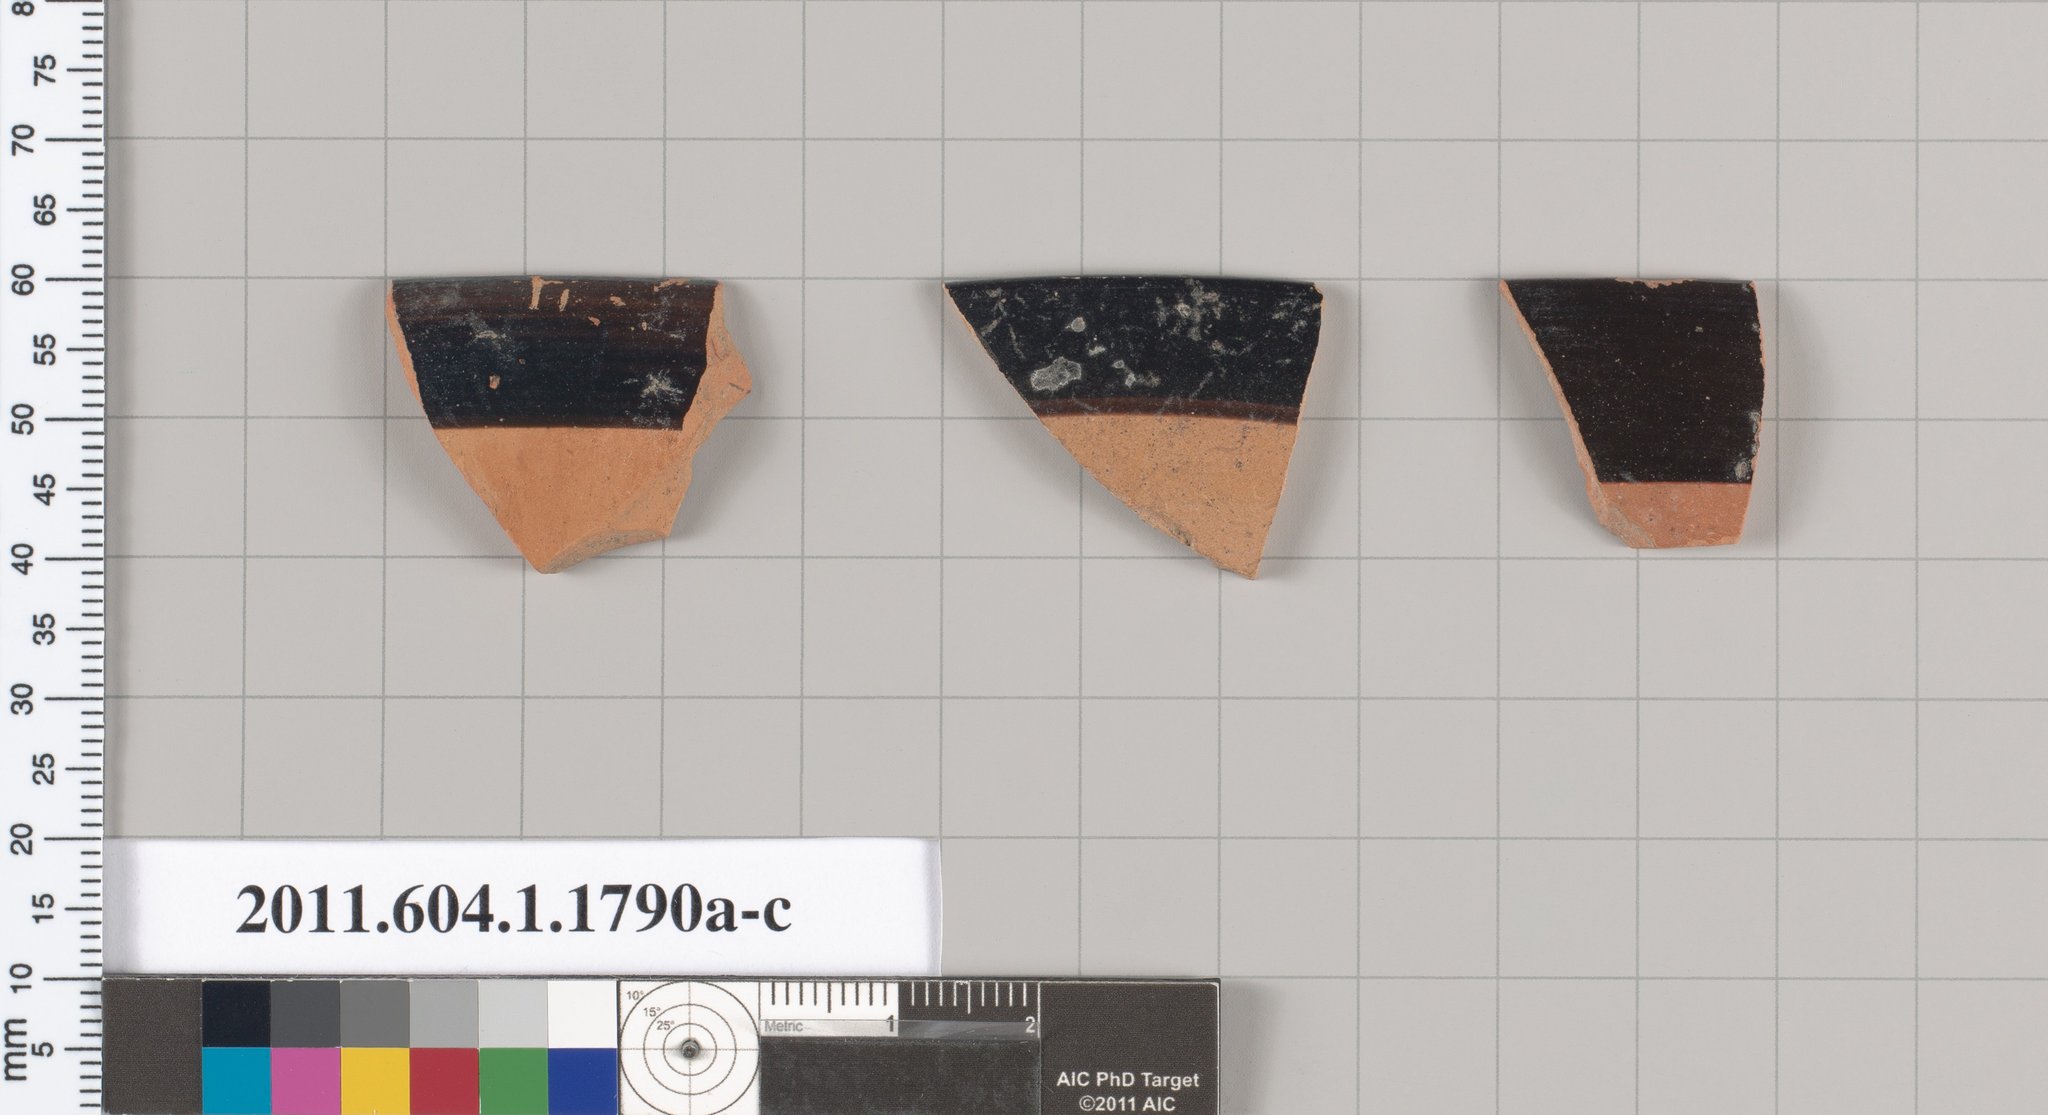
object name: kylix fragment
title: Terracotta rim fragments of kylikes(drinking cups)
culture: greek, attic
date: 500-401 BCE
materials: terracotta